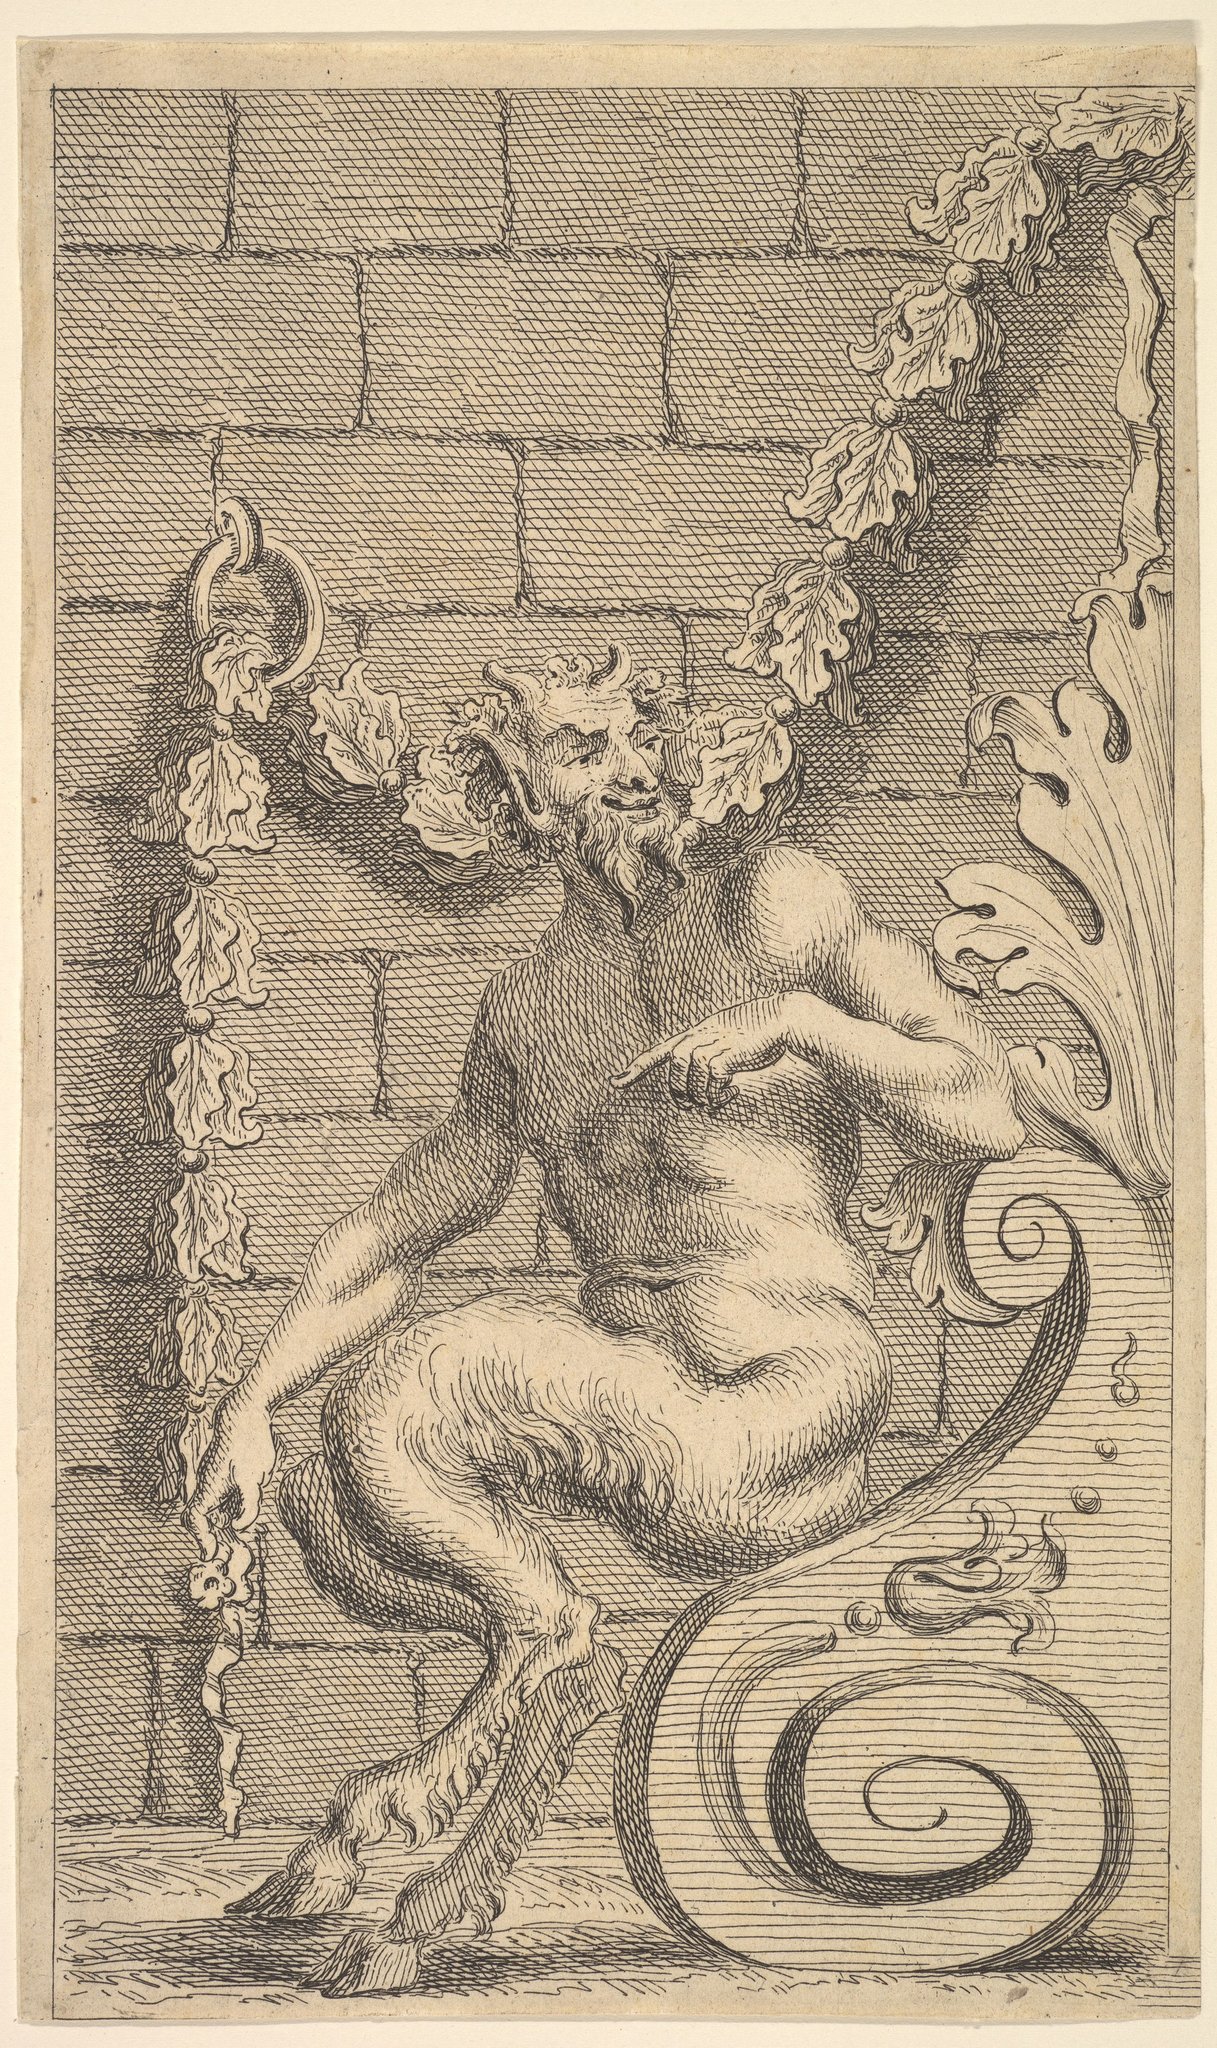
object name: print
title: Sitting Satyrs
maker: g. king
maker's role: artist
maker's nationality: british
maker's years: 1649-1832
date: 1732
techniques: engraving, etching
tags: garlands,satyrs